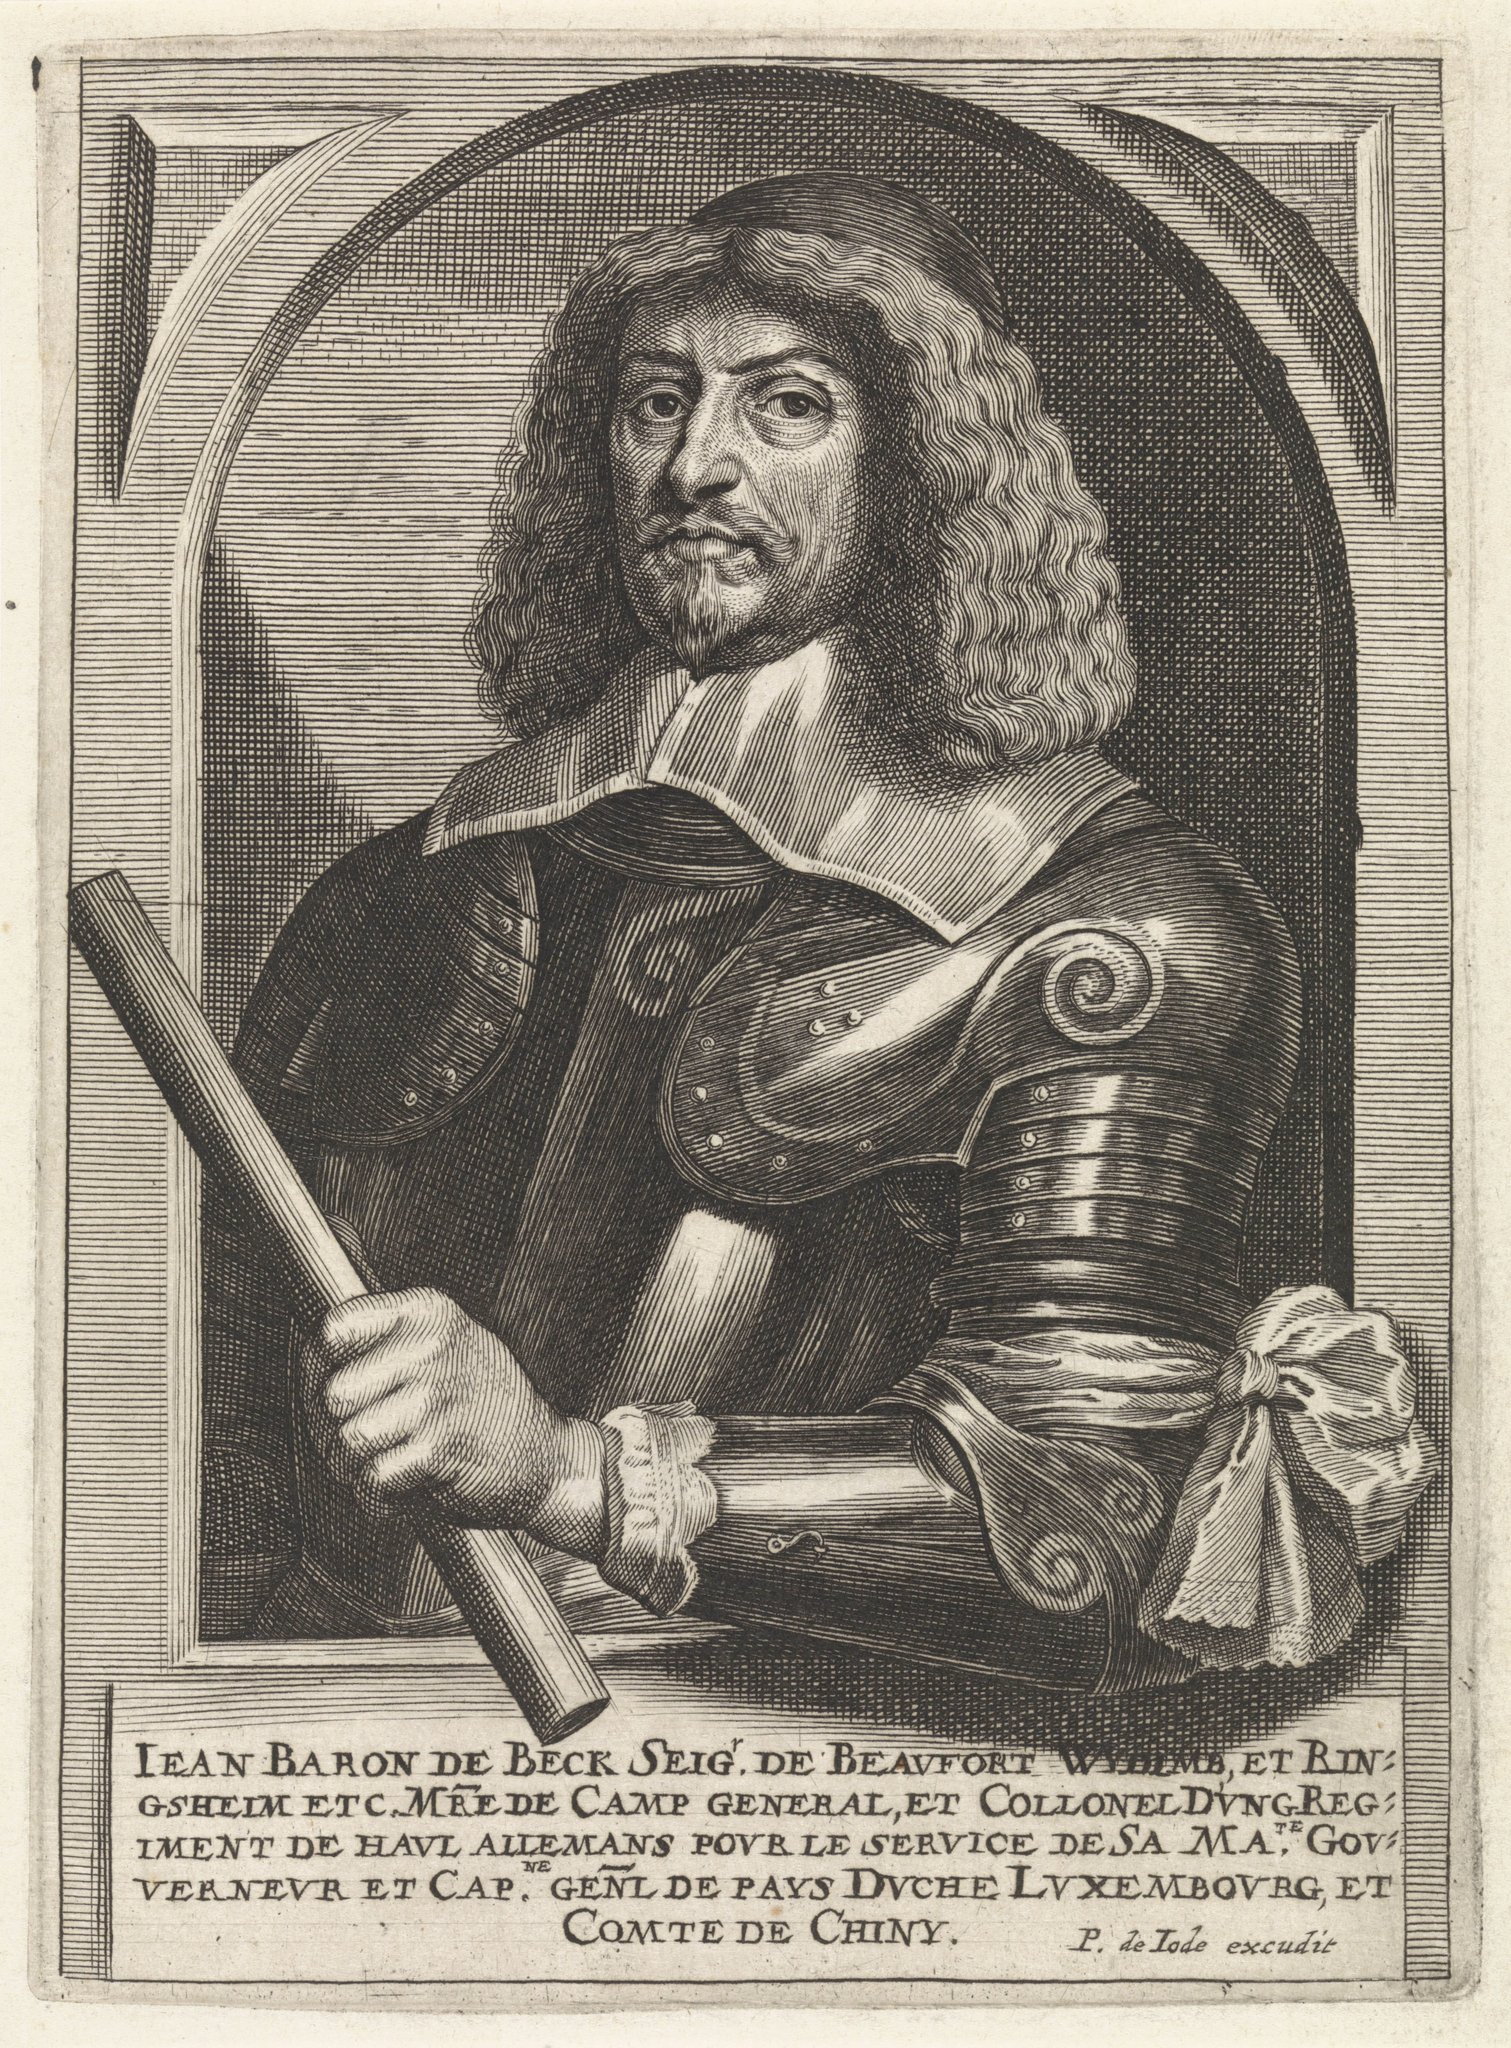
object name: print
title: Theater van bisschoppen, keizers, koningen, hertogen, prinsen, enz.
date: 1628-1670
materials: paper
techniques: engraving, etching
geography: antwerp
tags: baton of general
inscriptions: collector's mark: Lugt 2228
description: Portret van Jean de Beck, ten halven lijve. Hij draagt een kalot en een harnas, in zijn linkerhand houdt hij een commandostaf. Om zijn linkerarm een strik. Het portret is gevat in een boogvormige omlijsting met een vijfregelig onderschrift in het Latijn.